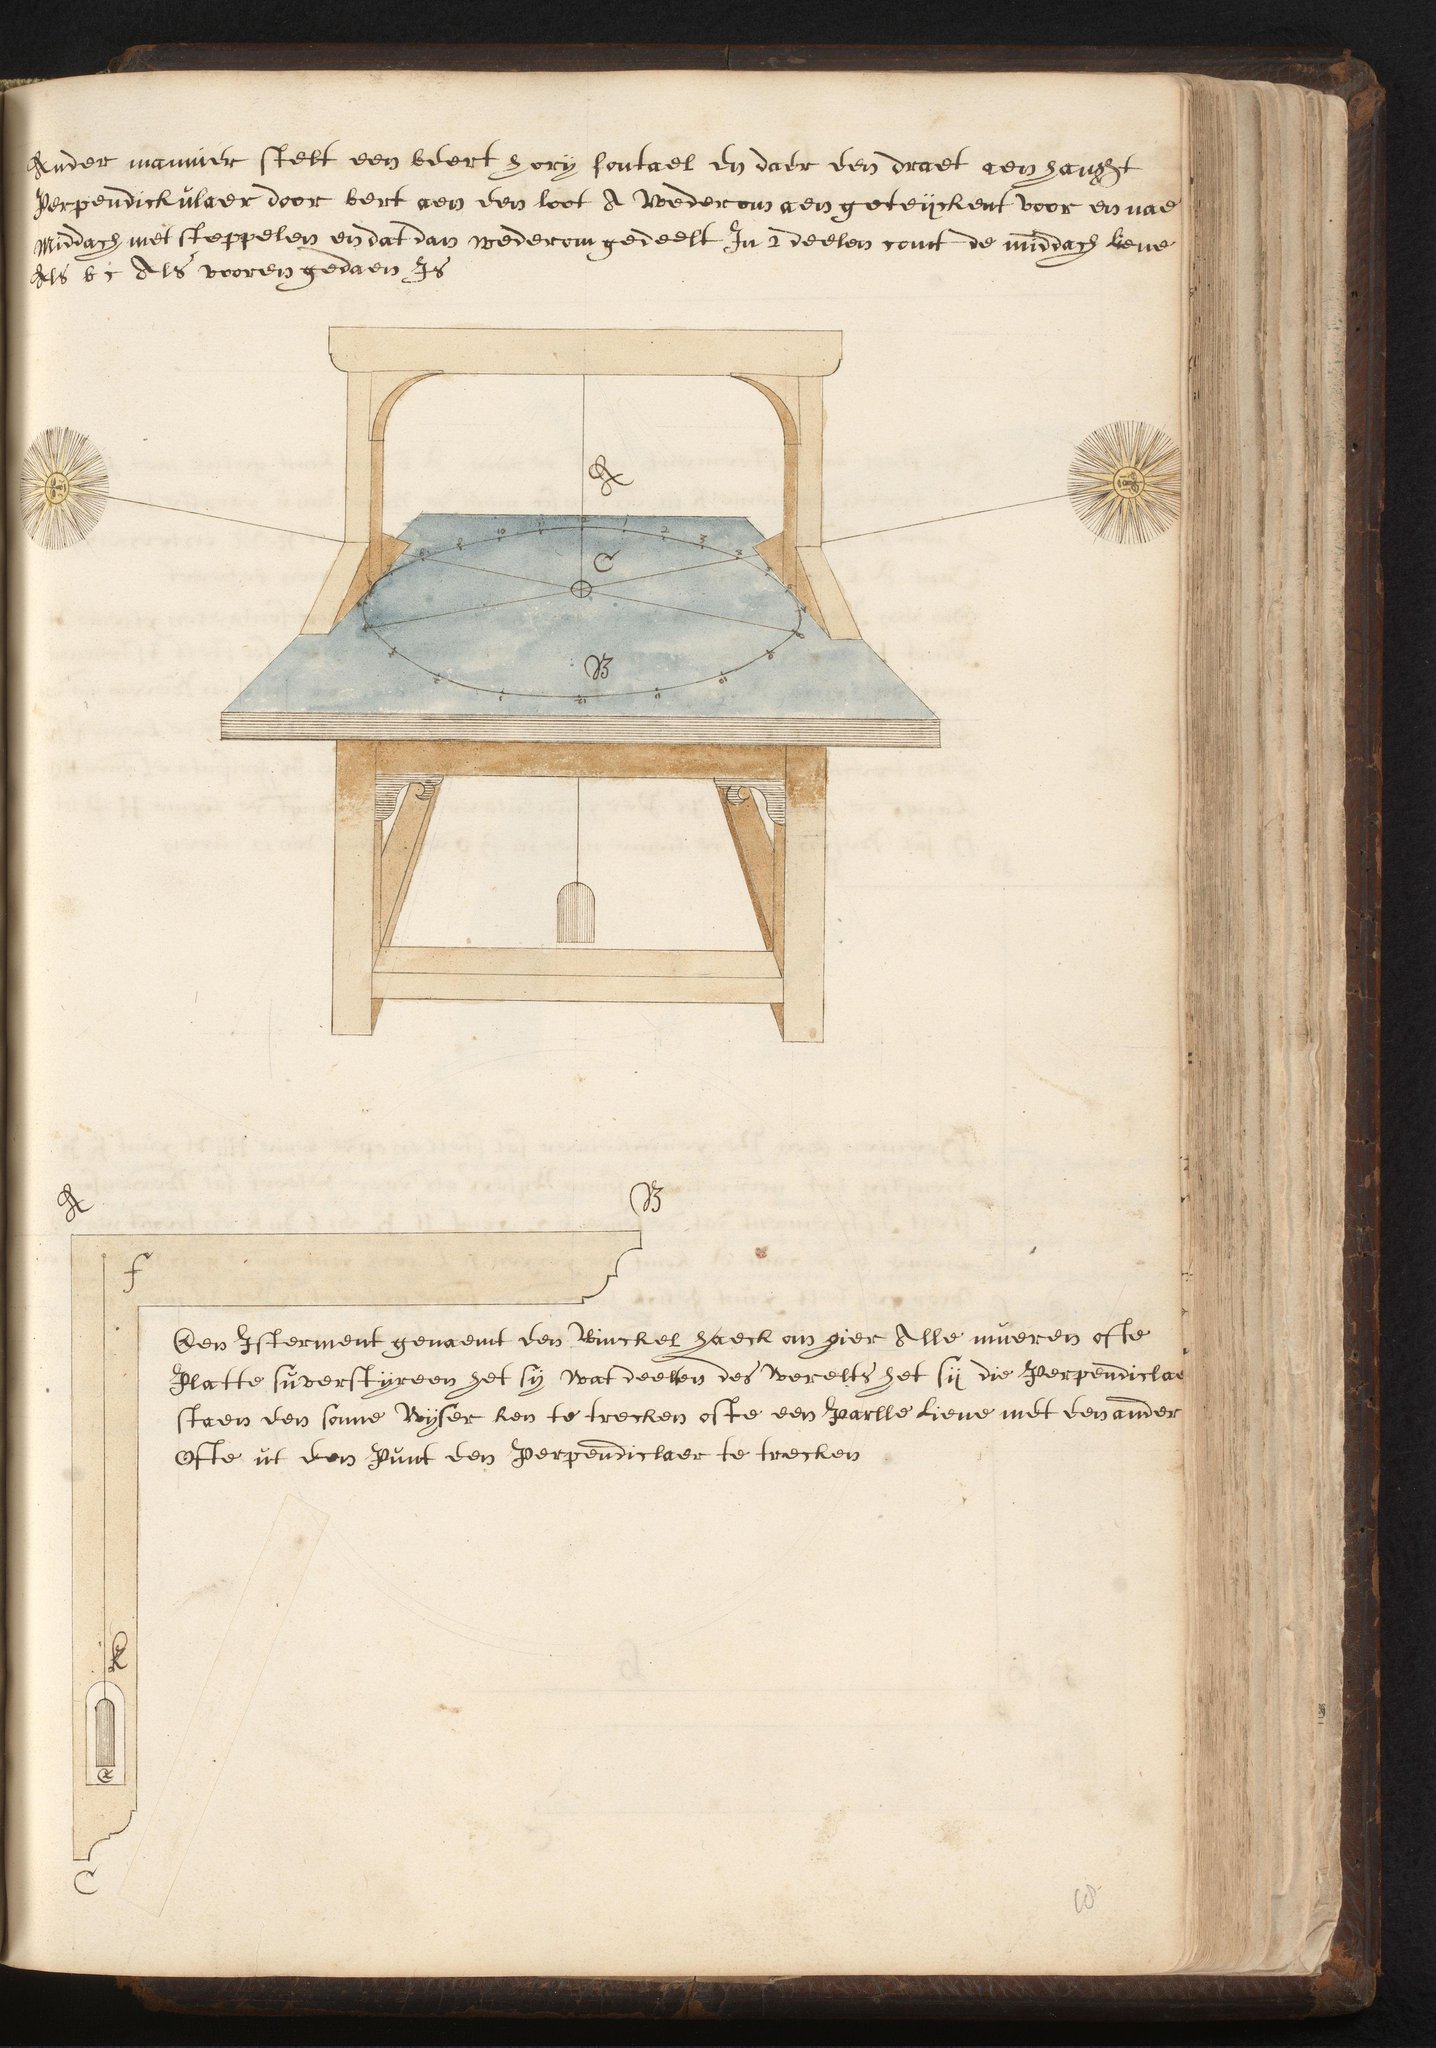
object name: album leaf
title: Horizontale zonnewijzer met detail van een onderdeel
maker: Anonymous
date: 1650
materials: ink, paper, pencil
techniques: brush, pen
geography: low countries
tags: sundial